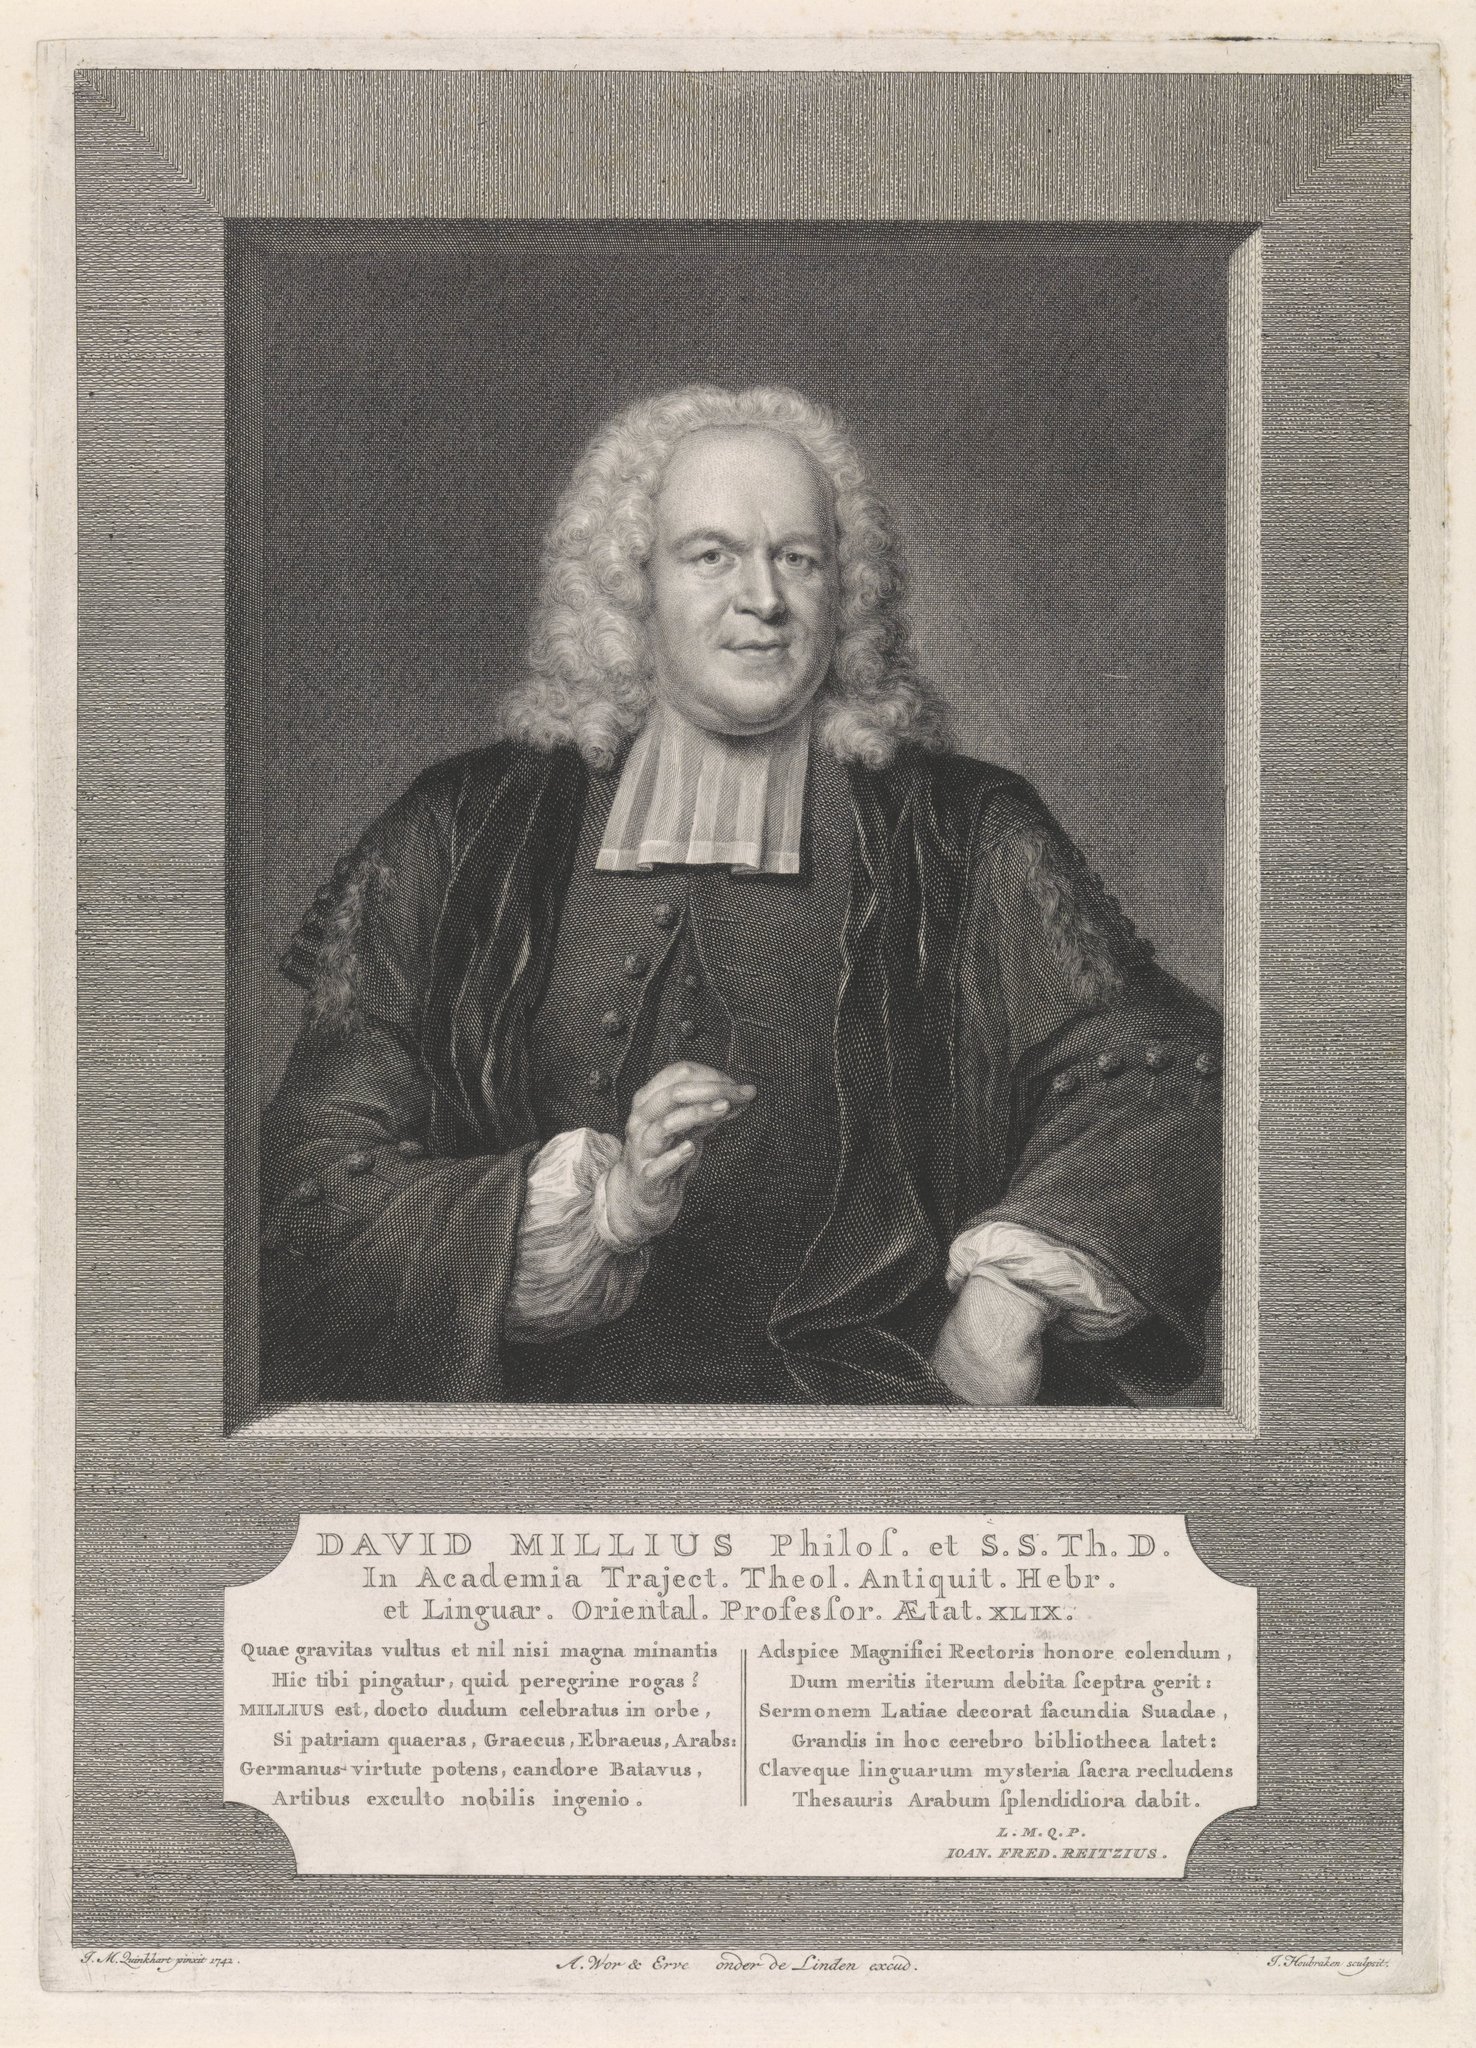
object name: print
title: David Millius (...)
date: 1742-1750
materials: paper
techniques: engraving, etching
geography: amsterdam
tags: utrecht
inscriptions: collector's mark: Lugt 240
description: Portret ten halven lijve van David Millius in een rechthoekig venster. Onder het portret zijn naam en gegevens in drie regels in het Latijn een daaronder twee kolommen met elk zes regels in het Latijn.